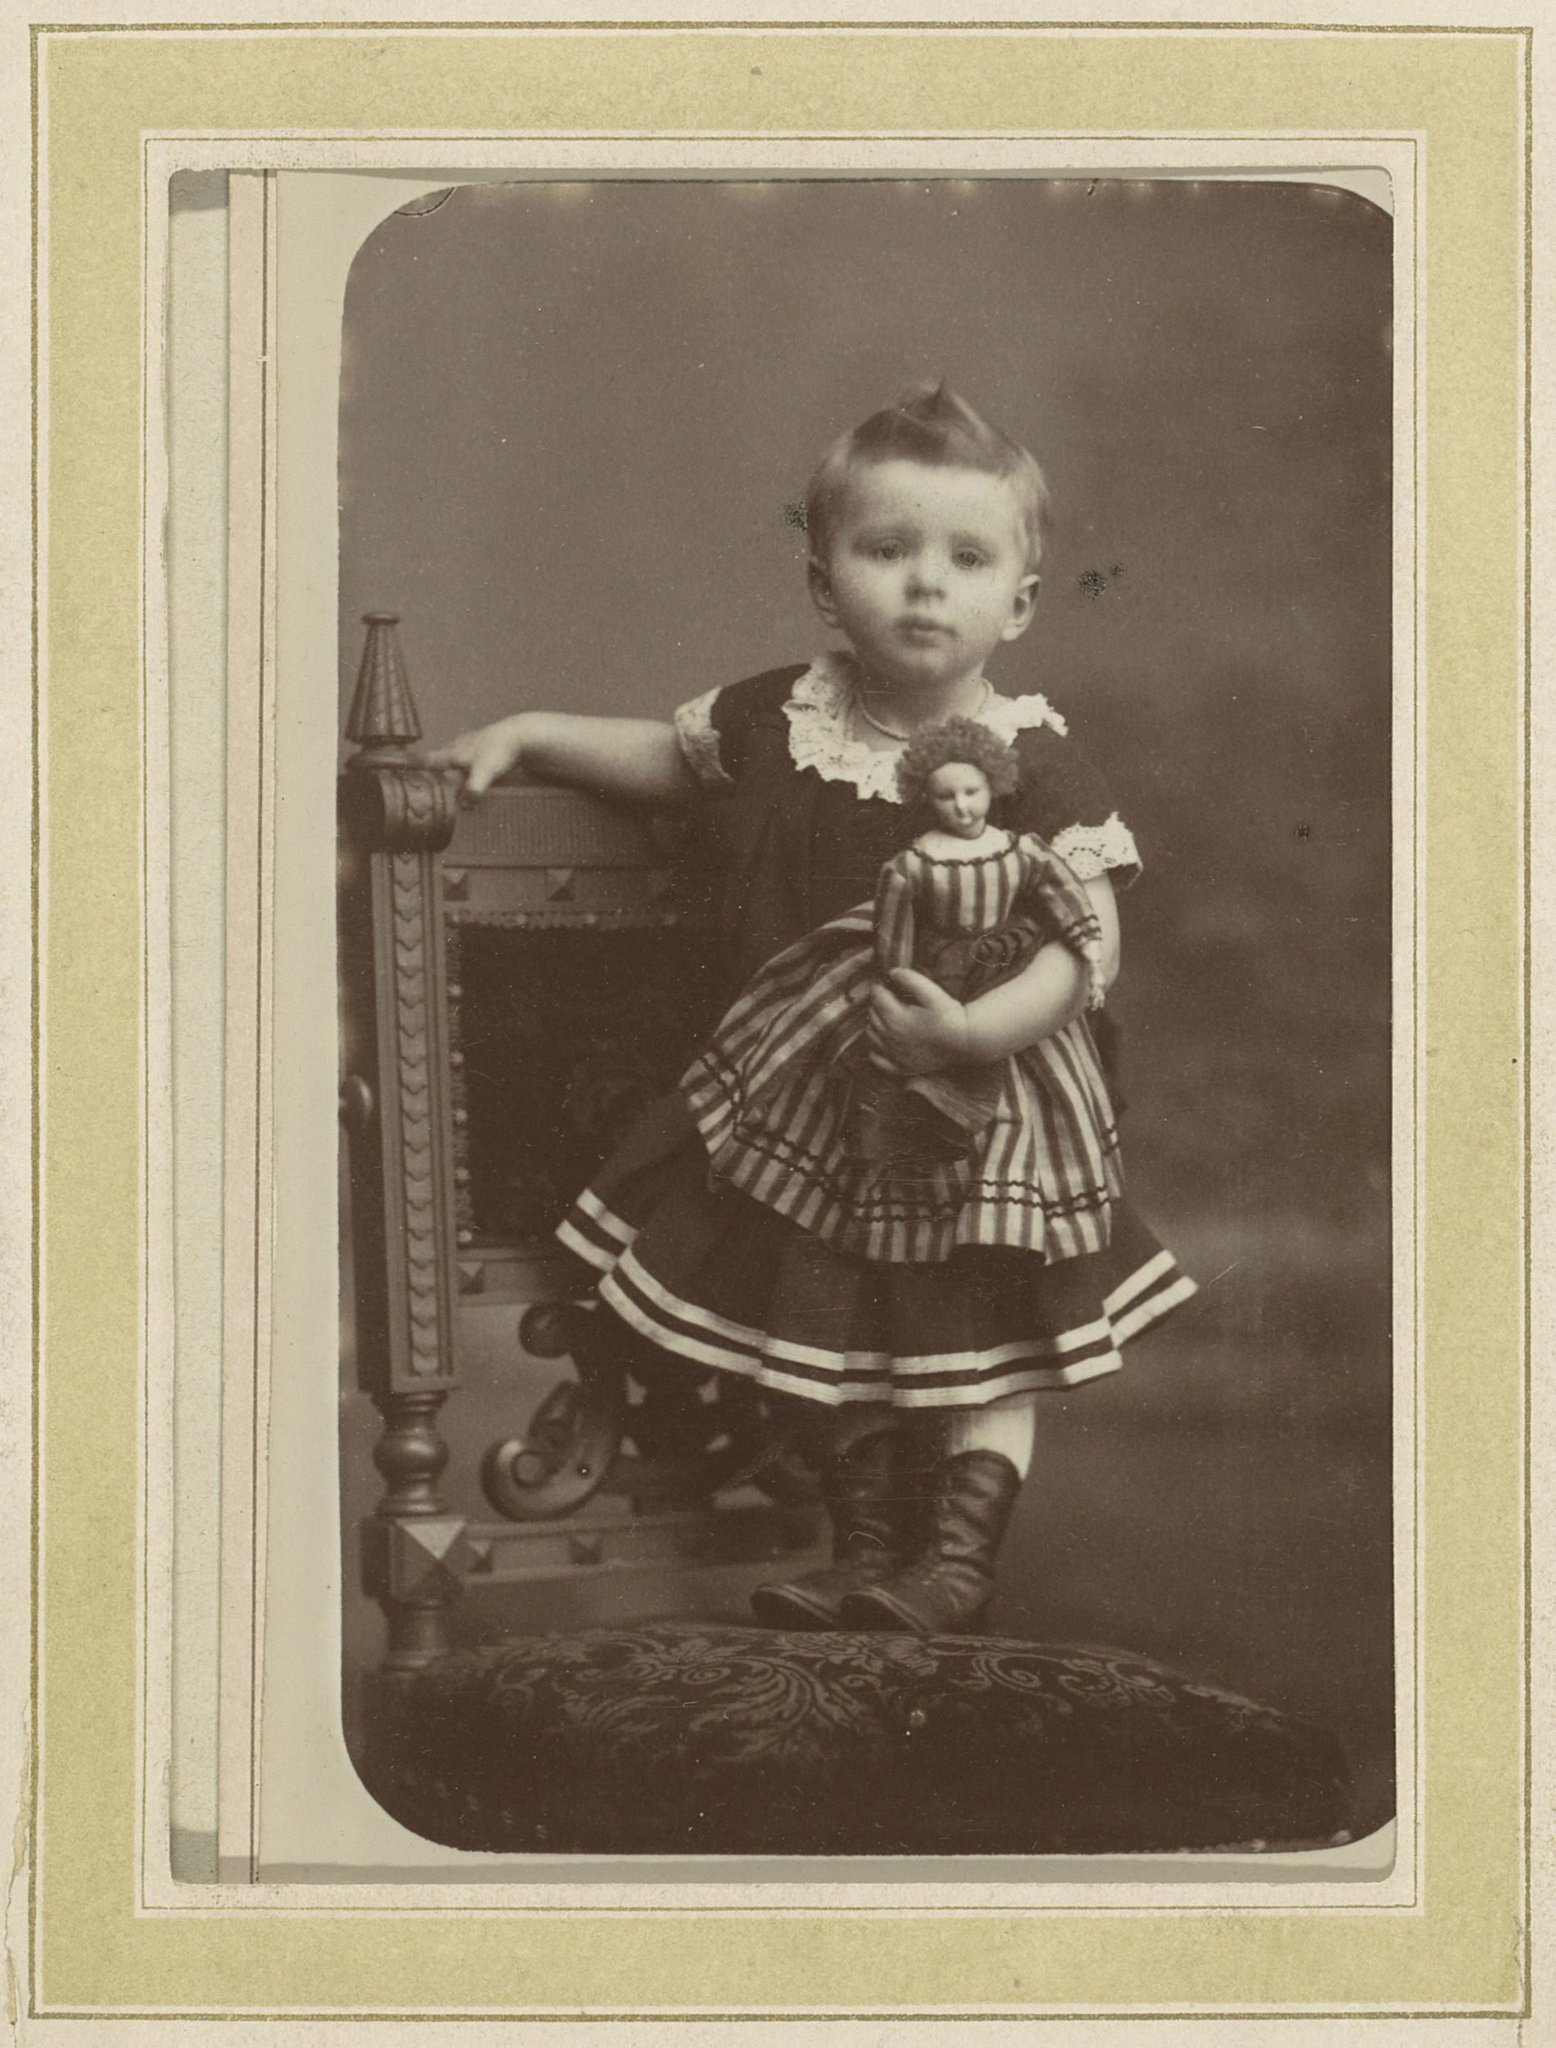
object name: cabinet photograph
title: Portret van een meisje in een gestreepte jurk op een stoel met een pop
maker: willem gerhardus kuijer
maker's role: fotograaf, hoffotograaf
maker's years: 1834-1899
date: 1870-1900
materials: cardboard, paper, photographic support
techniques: albumen print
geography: amsterdam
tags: studio requisites ~ photographer, clothing for the lower part of the body, historical persons, clothing for the upper part of the body, gear for legs and feet, (playing with) dolls, amsterdam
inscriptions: address: ‘Westermarkt 19 Amsterdam’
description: Onderdeel van Fotoalbum van een Nederlandse familie met 168 cartes-de-visite en kabinetfoto's.